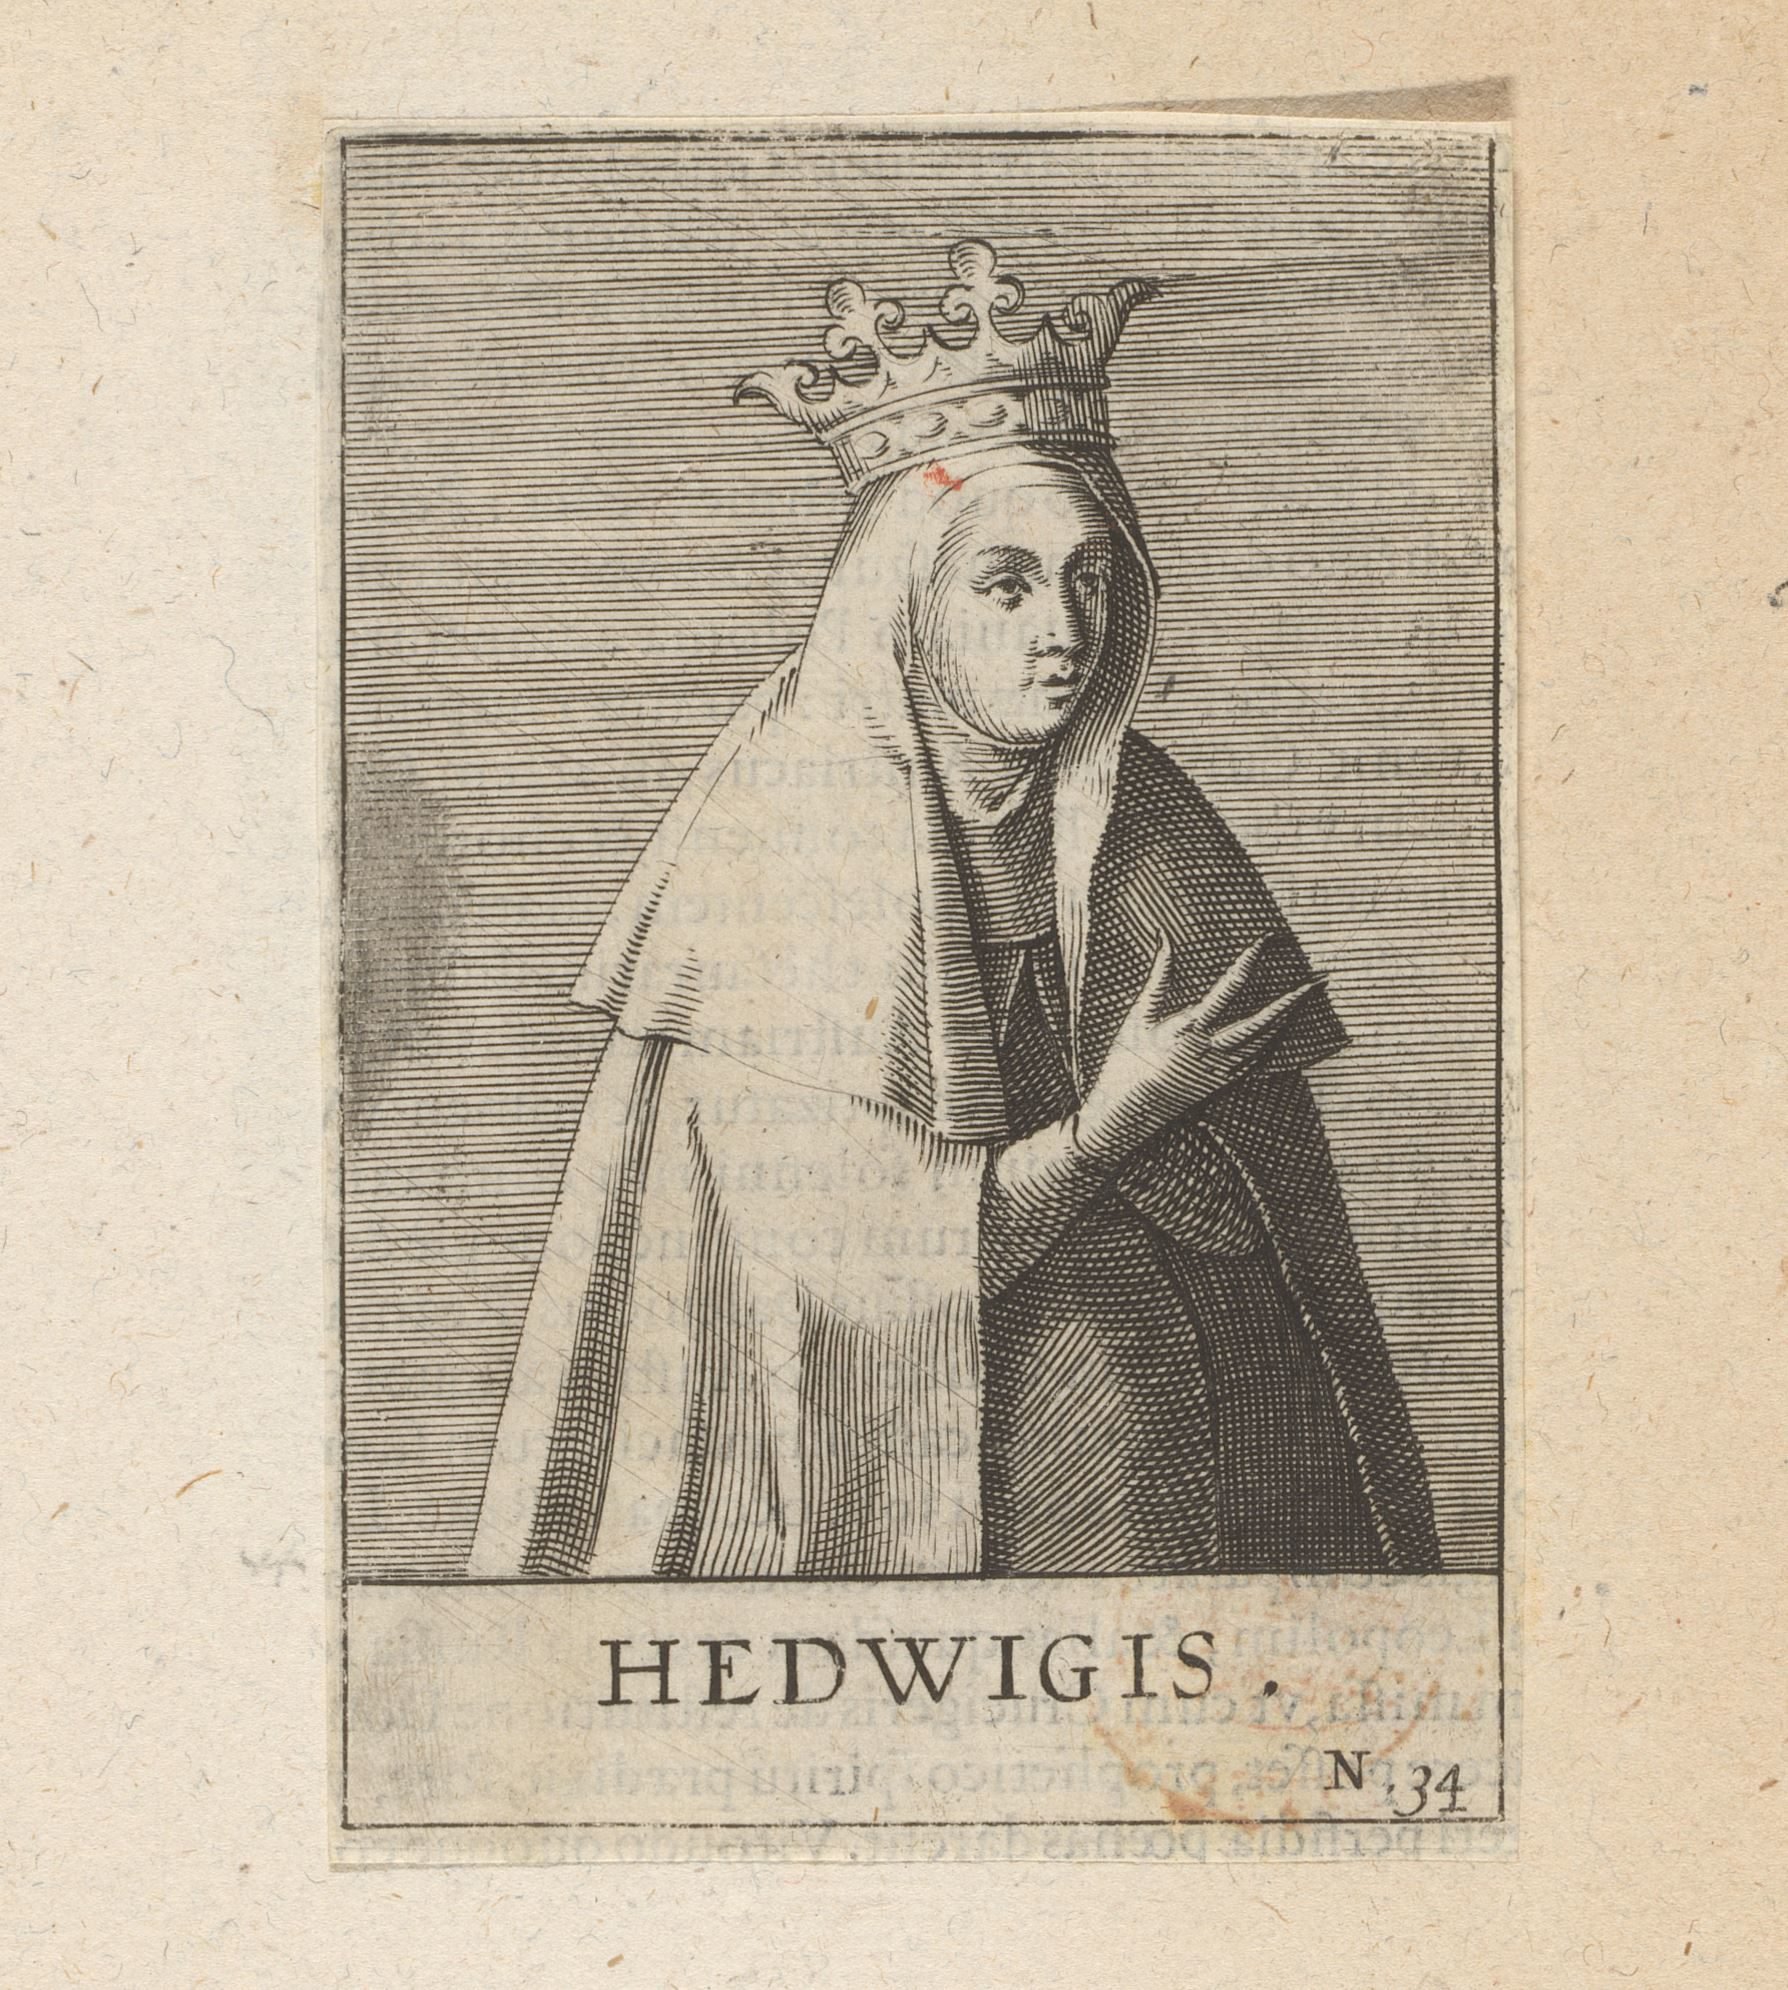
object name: book illustration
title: Portret van Hedwig van Silezië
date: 1574-1594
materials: paper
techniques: woodcut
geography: cologne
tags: historical persons, ruler, sovereign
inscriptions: collector's mark: Lugt 240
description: Prent gebruikt in: Mylius, Arnold. Principum et Regum Polonorum Imagines ad Vivum Expressae (...). Keulen: Gottfried von Kempen, 1594.